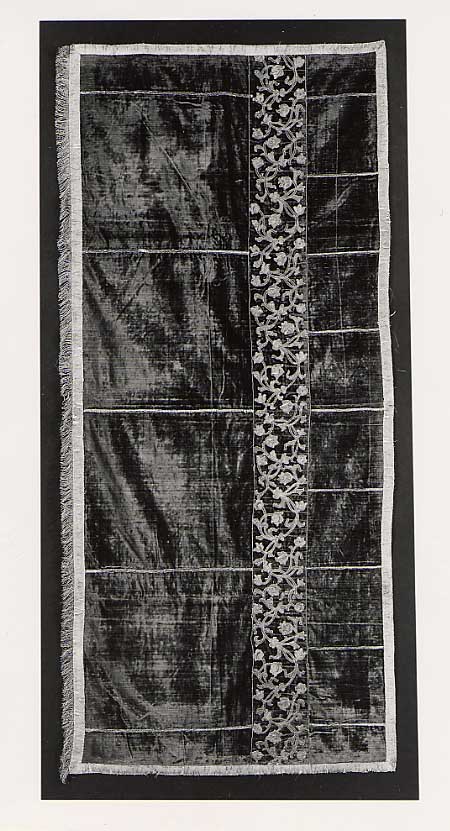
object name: antependium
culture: italian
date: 1401-1500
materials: metal, silk